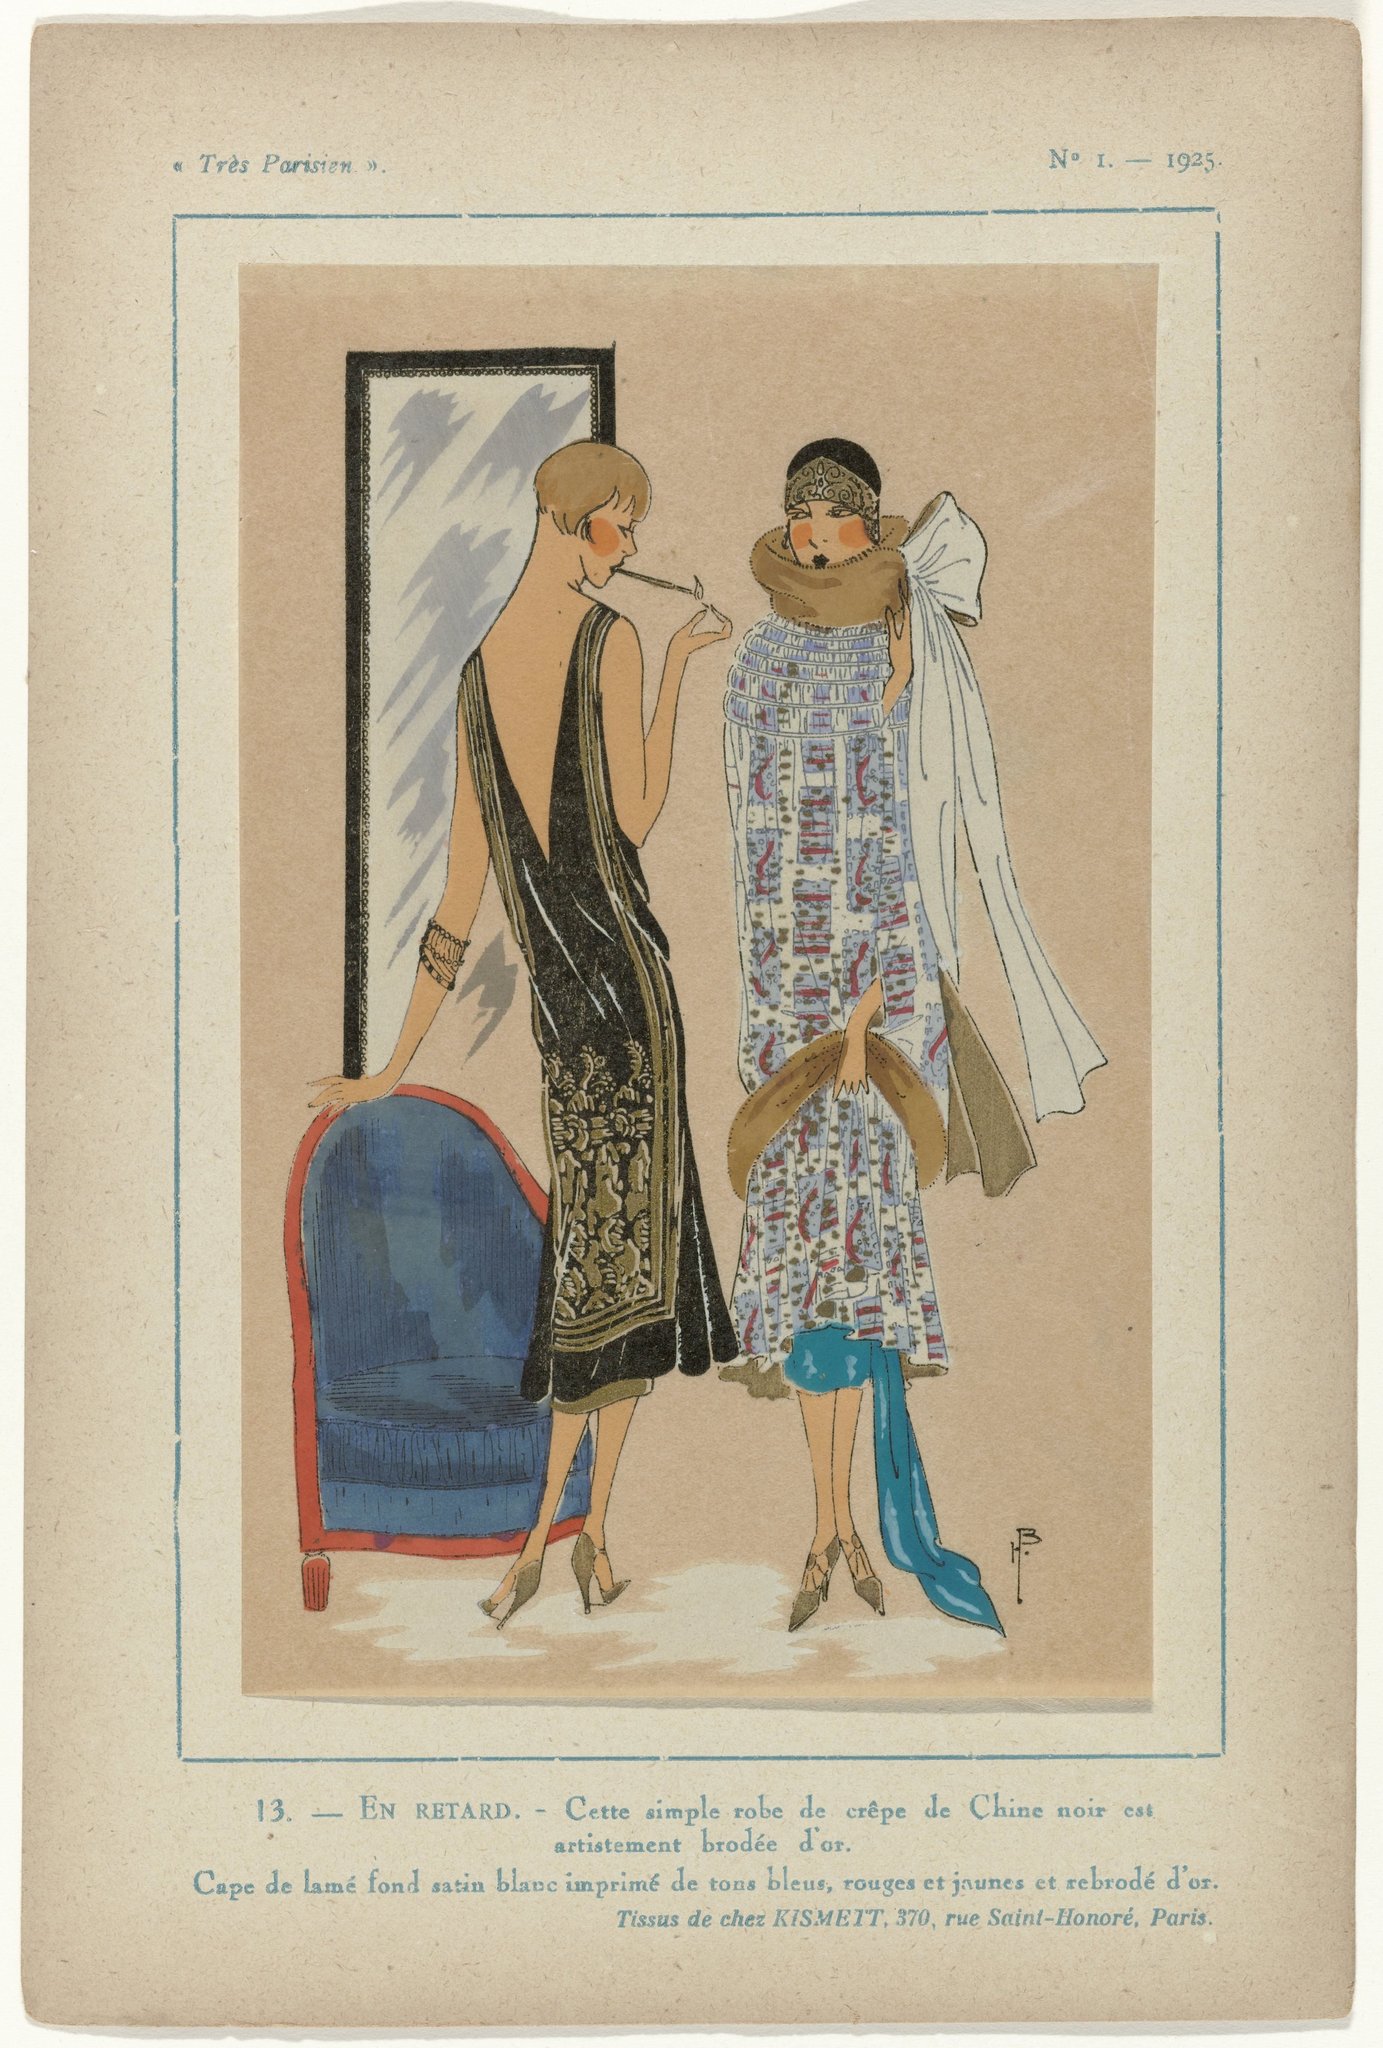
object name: fashion print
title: Très Parisien. La Mode, Le Chic, L’Elégance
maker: g-p. joumard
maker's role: publisher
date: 1925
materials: paper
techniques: hand coloring, letterpress printing, lithography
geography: paris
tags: dress, gown: evening dress (+ women's clothes), cigarette, coat (evening coat) (+ women's clothes), mirror, head-gear: cap (+ women's clothes), fashion plates, bracelet, wristlet (+ women's clothes)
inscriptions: caption: ‘EN RETARD - Cette simple robe de crêpe de Chine noir est artistement brodée d'or. Cape de lamé fond satin blanc imprimé de tons bleus, rouges et jaunes er rebrodé d'or. Tissus de chez Kismett, 370, rue Saint-Honoré, Paris’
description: Très Parisien promoted itself as chic and elegant. Between 1920 and 1936 it presented creations by such couturiers as Chéruit, Premet, Philip et Gaston, and Lanvin. The young, svelte models are all ultra-modern, shown talking on the phone, smoking and playing tennis. The illustrations also show that over the course of the 1920s, skirt lengths had risen to just below the knee, before dropping back down to calf length in the 1930s. The small plates were printed on transparent paper using a stencilling technique known as en pochoir and then hand coloured; many of them are unsigned. The signature ‘Joujou’ belonged to Germaine Paule Joumard, who was the director of Très Parisien, as well as one of the magazine’s illustrators.